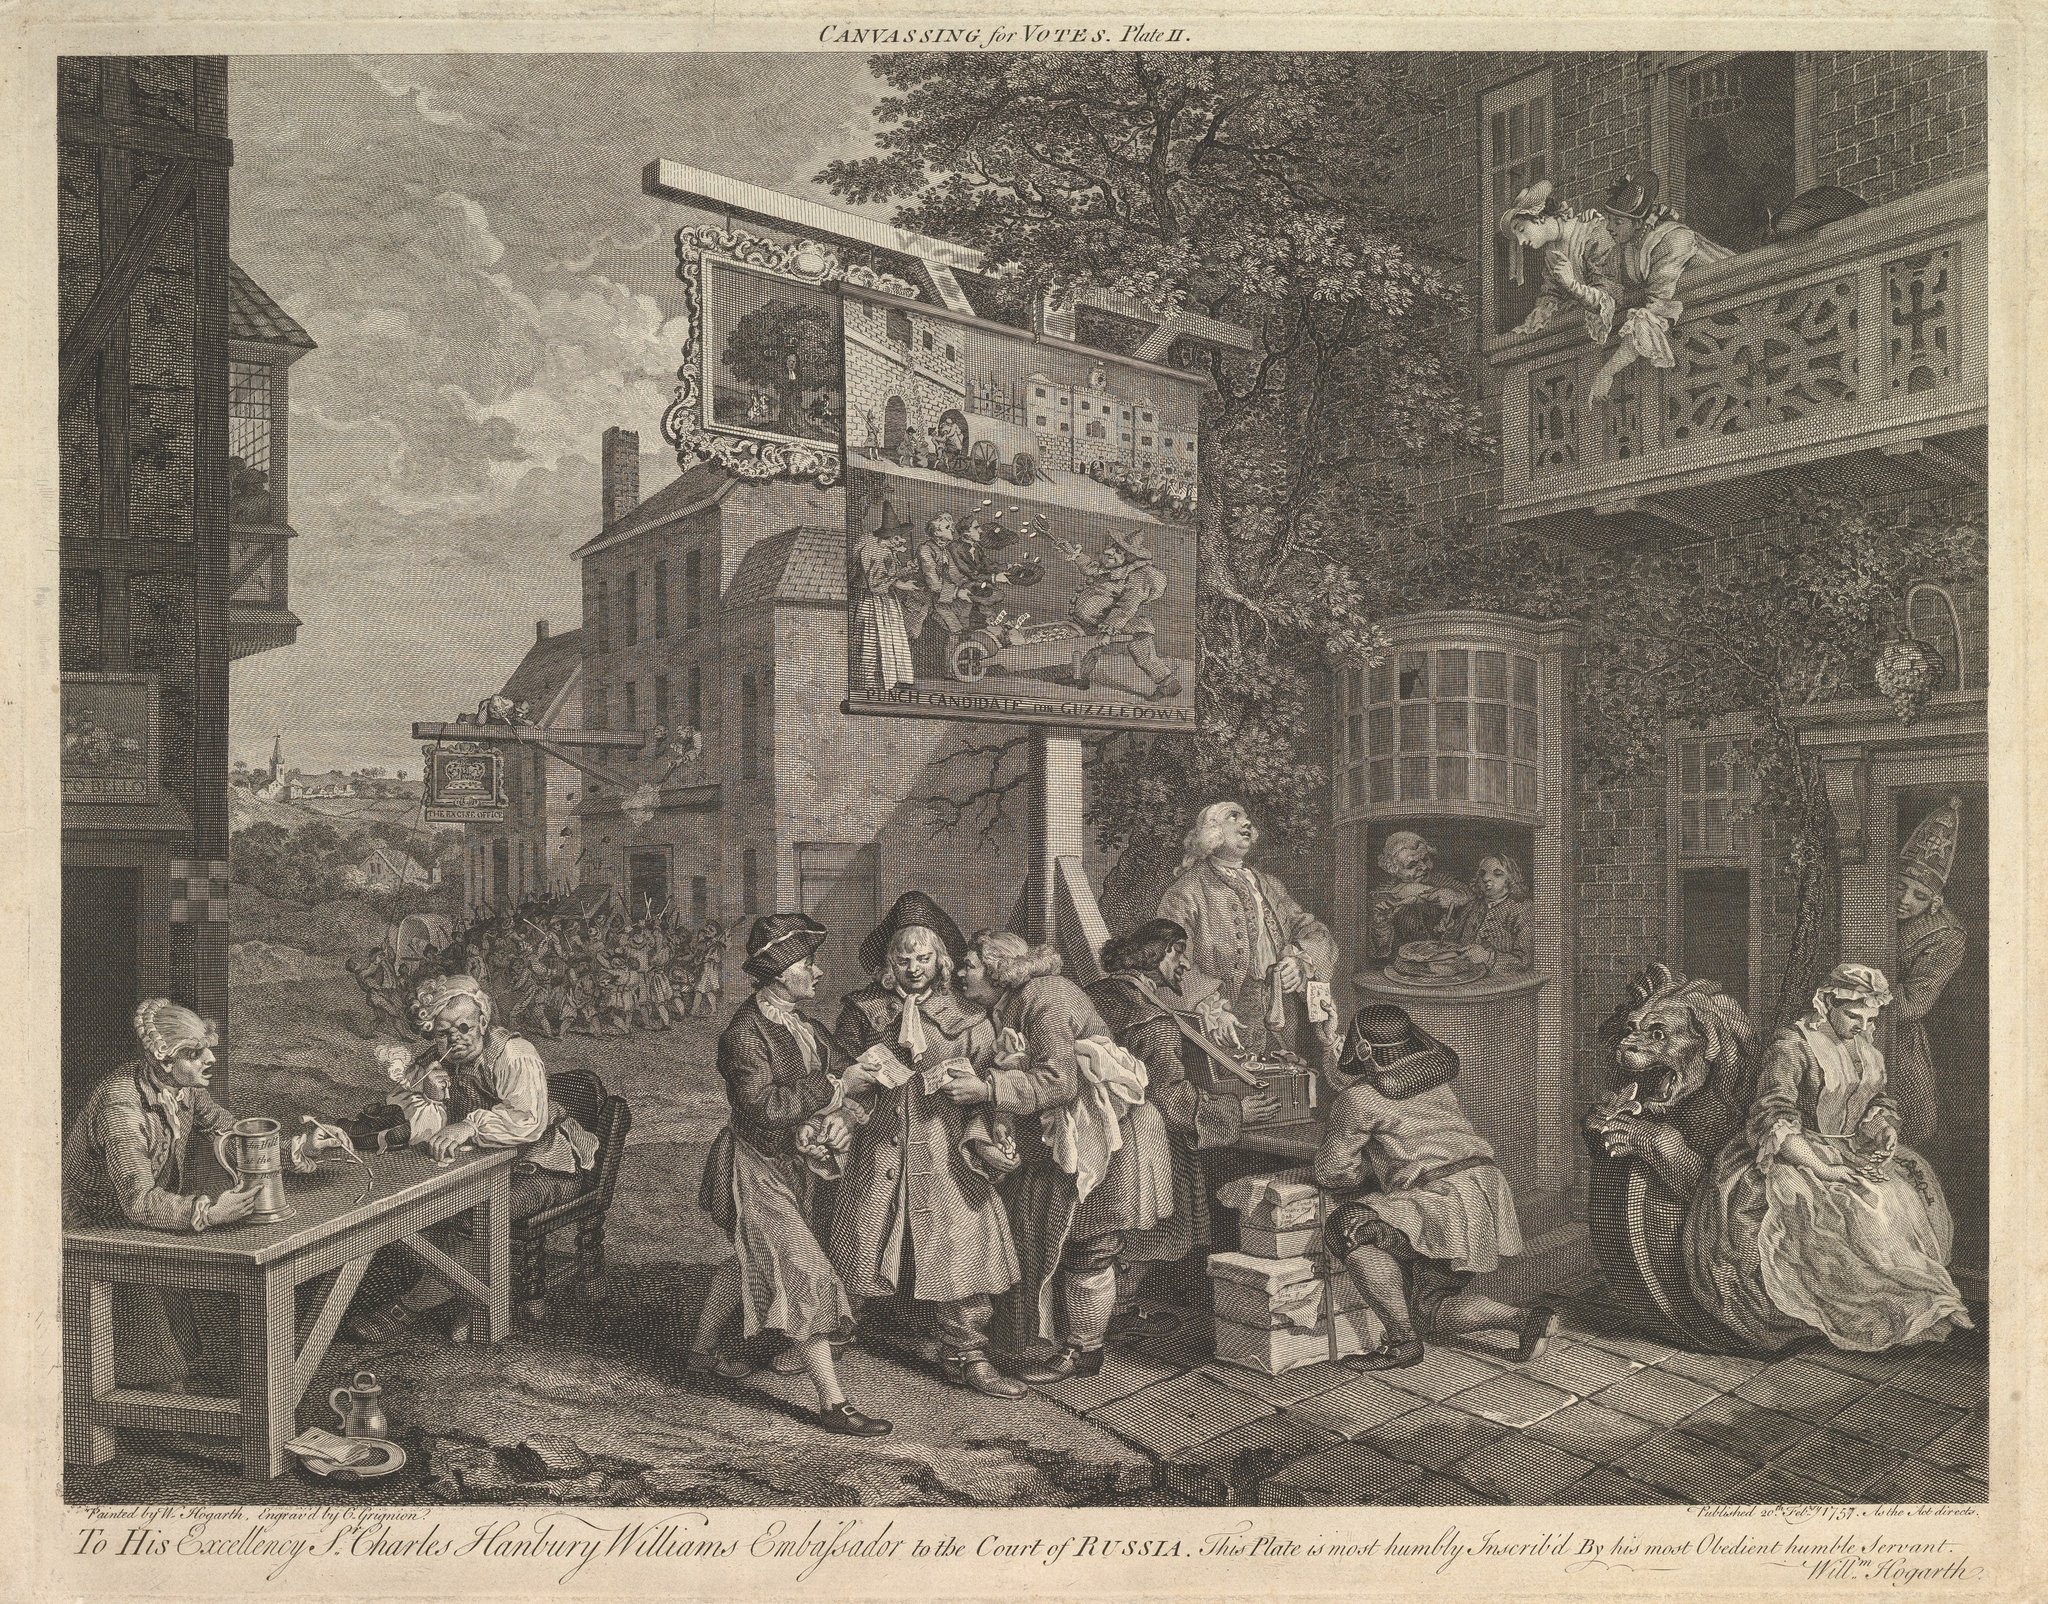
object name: print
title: Canvassing for Votes, Plate II: Four Prints of an Election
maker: charles grignion, i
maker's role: engraver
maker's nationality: british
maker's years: 1710-1810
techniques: engraving, etching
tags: buildings,elections,men,women